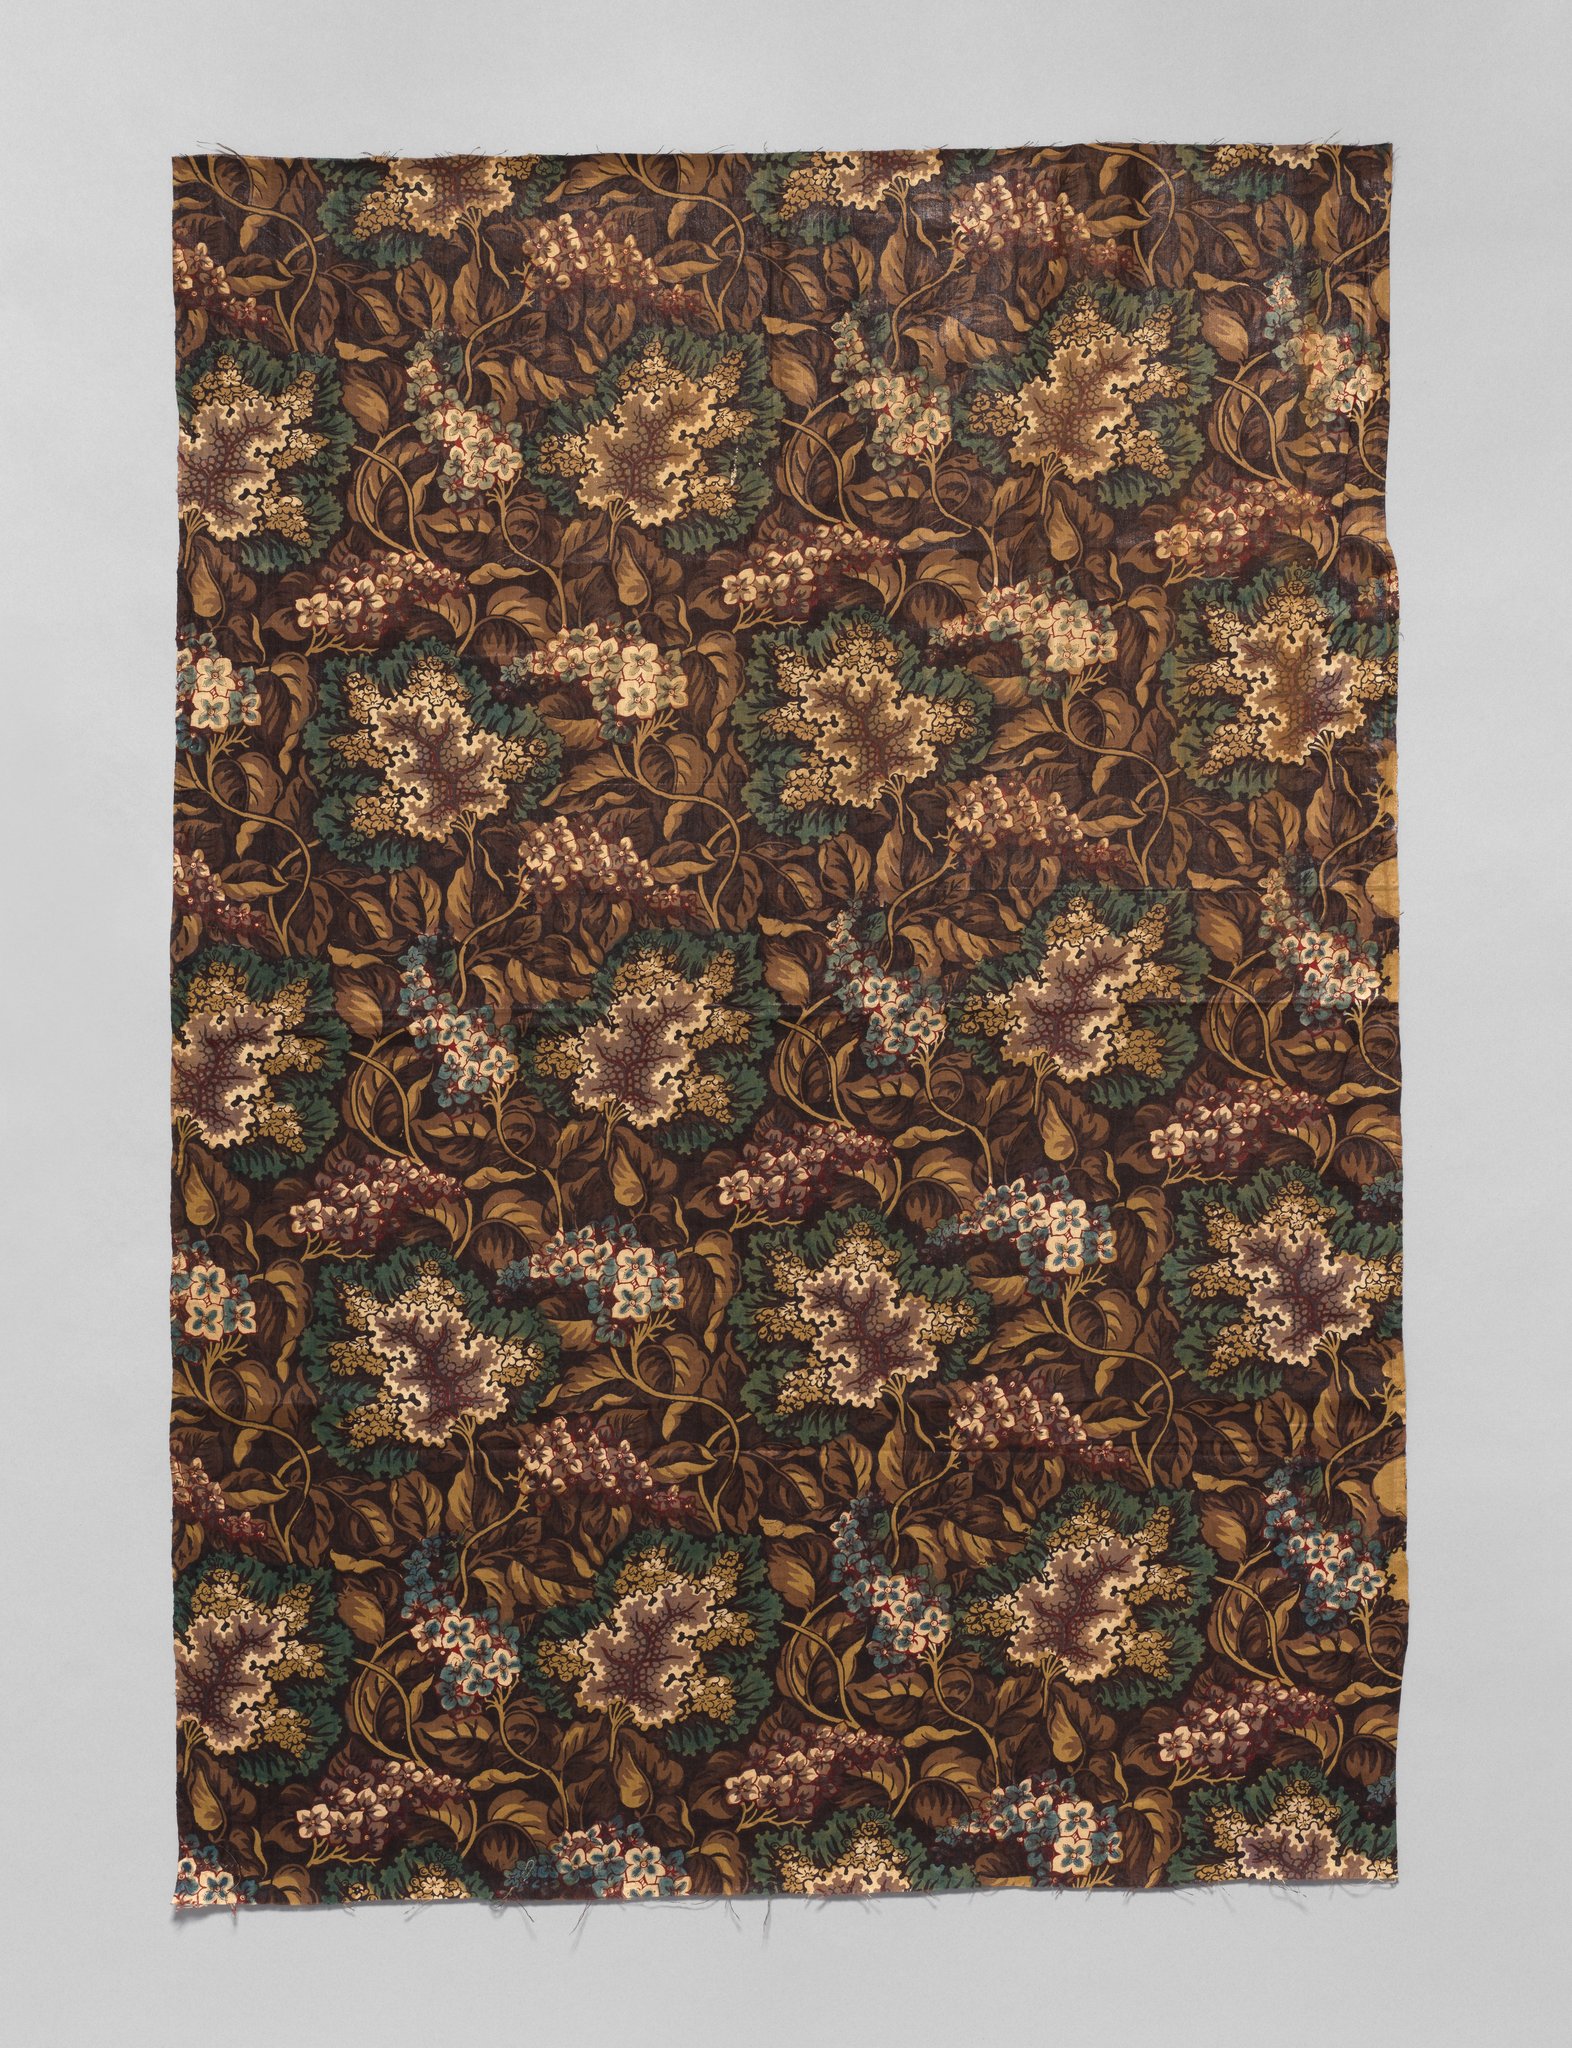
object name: piece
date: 1800-1810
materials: cotton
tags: flowers